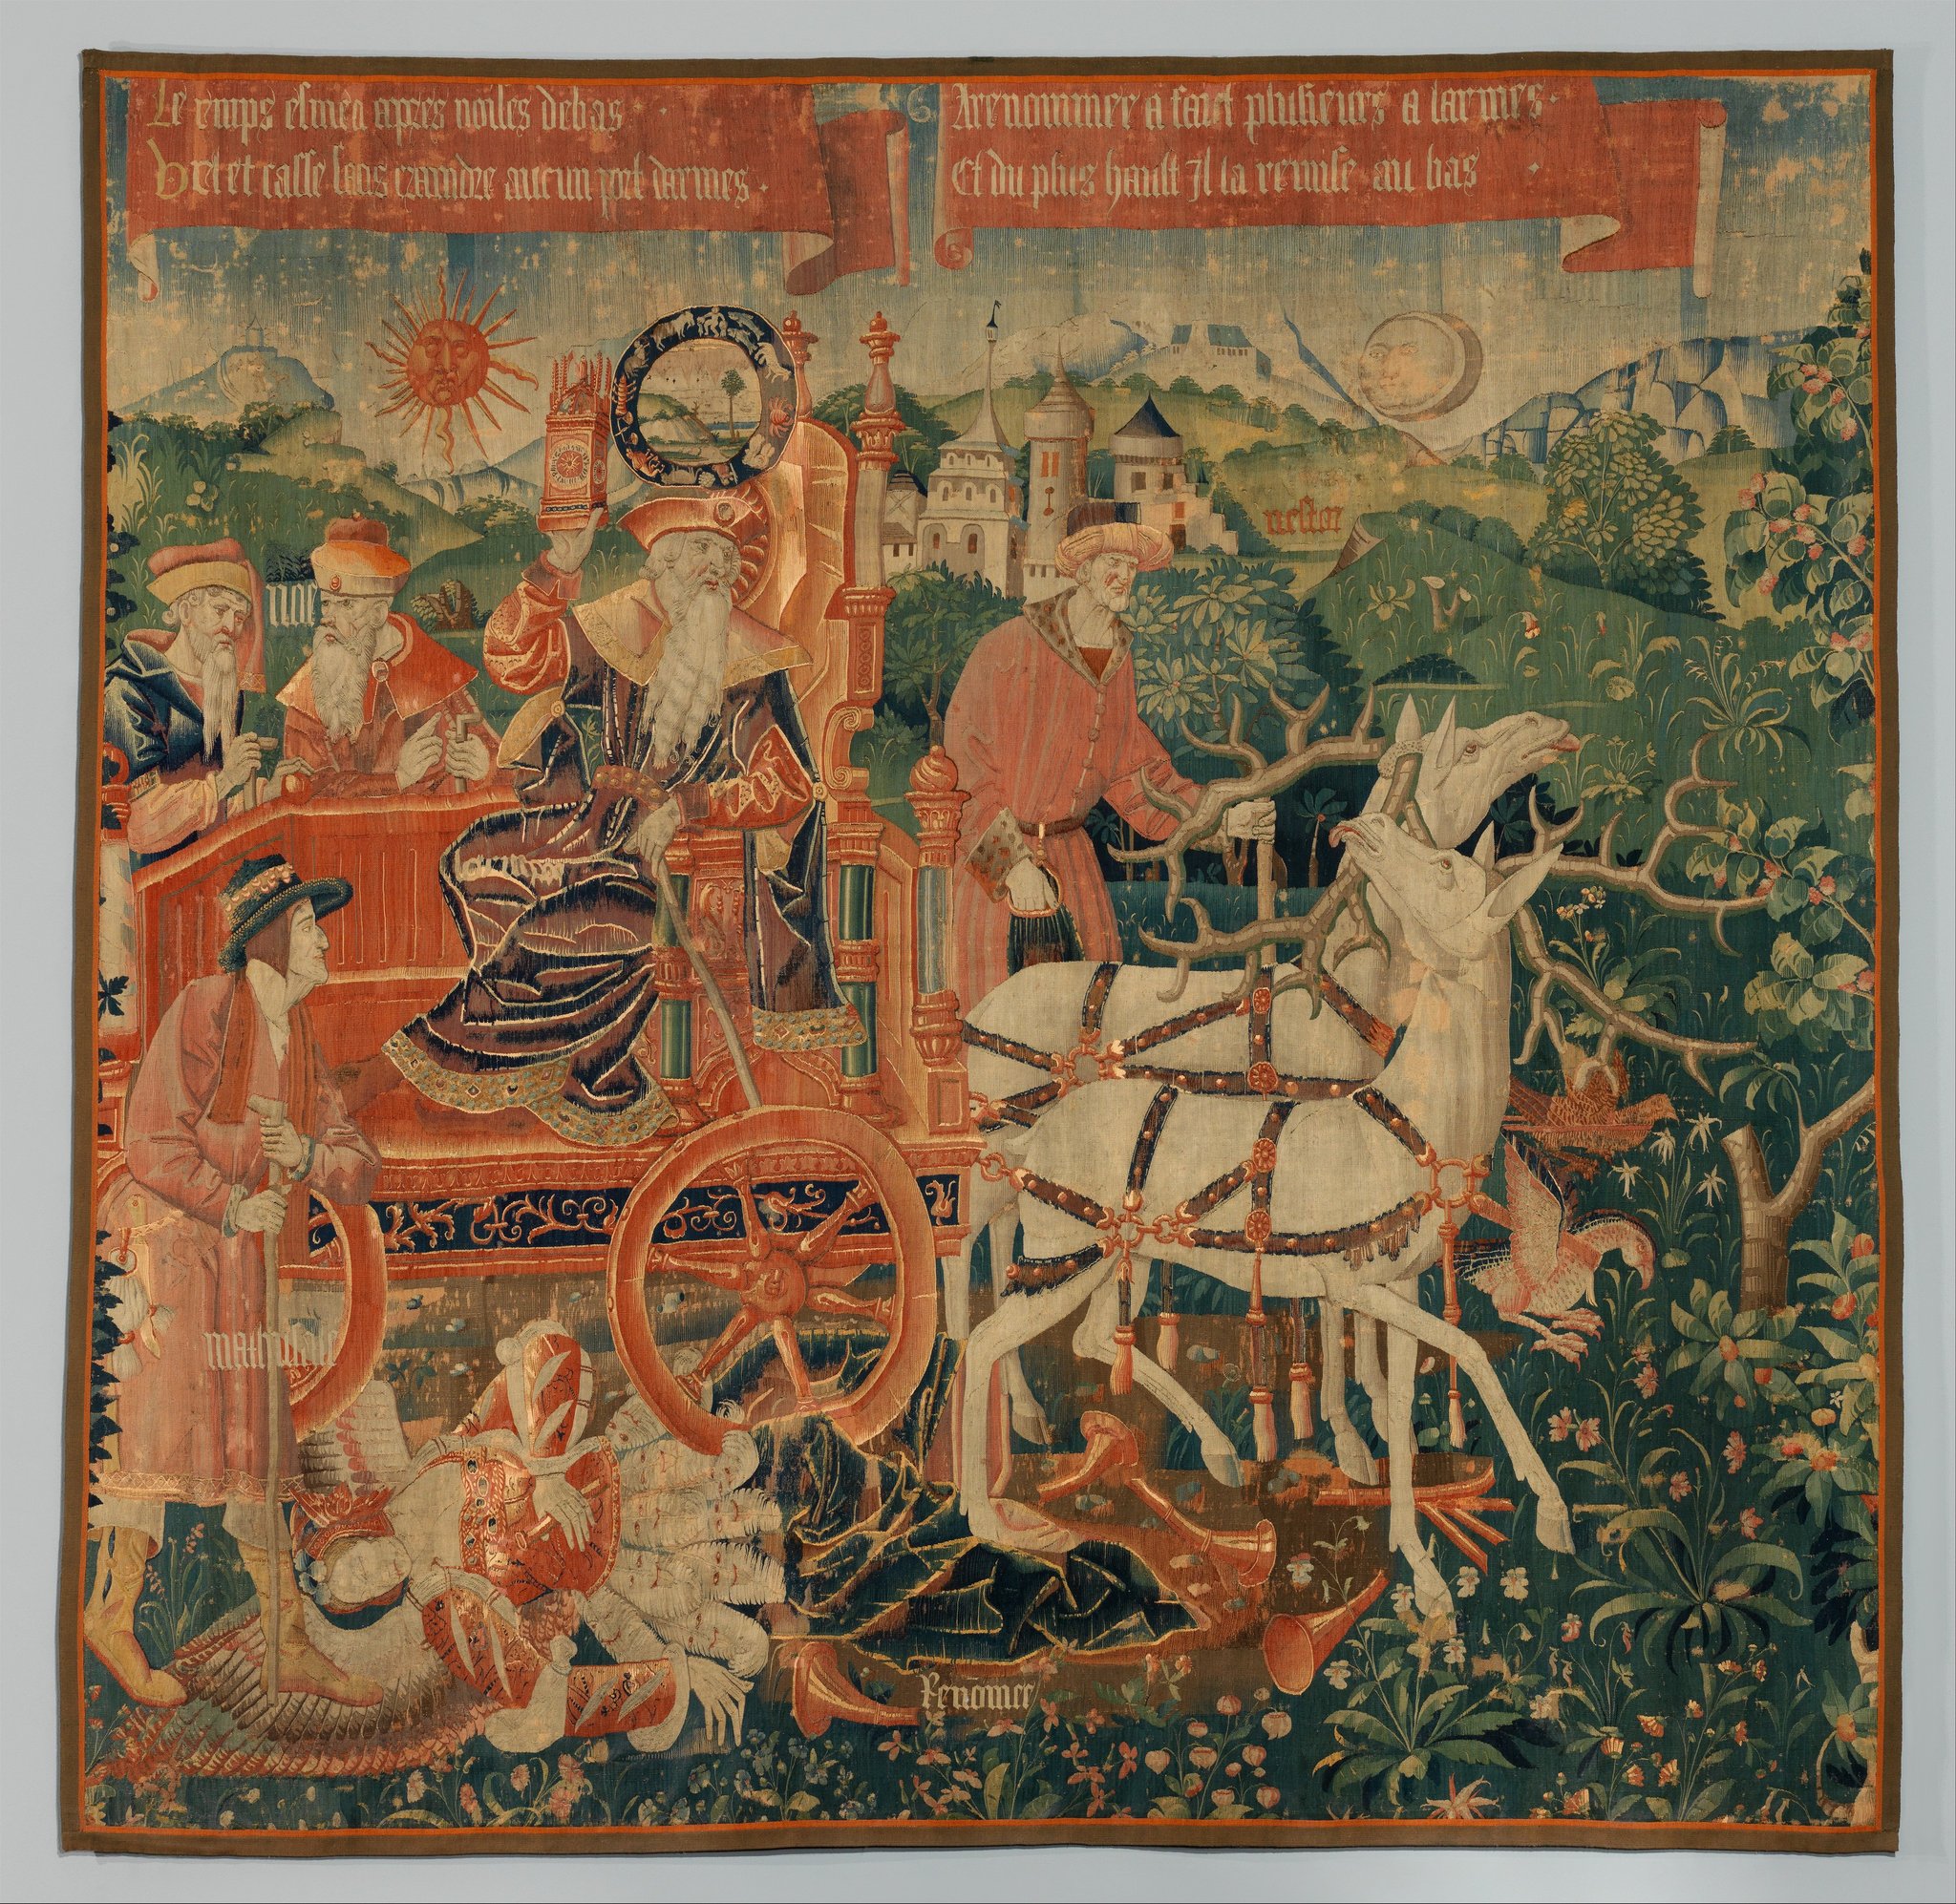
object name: tapestry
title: The Triumph of Time over Fame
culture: south netherlandish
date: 1500-1530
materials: silk, wool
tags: birds,men,deer